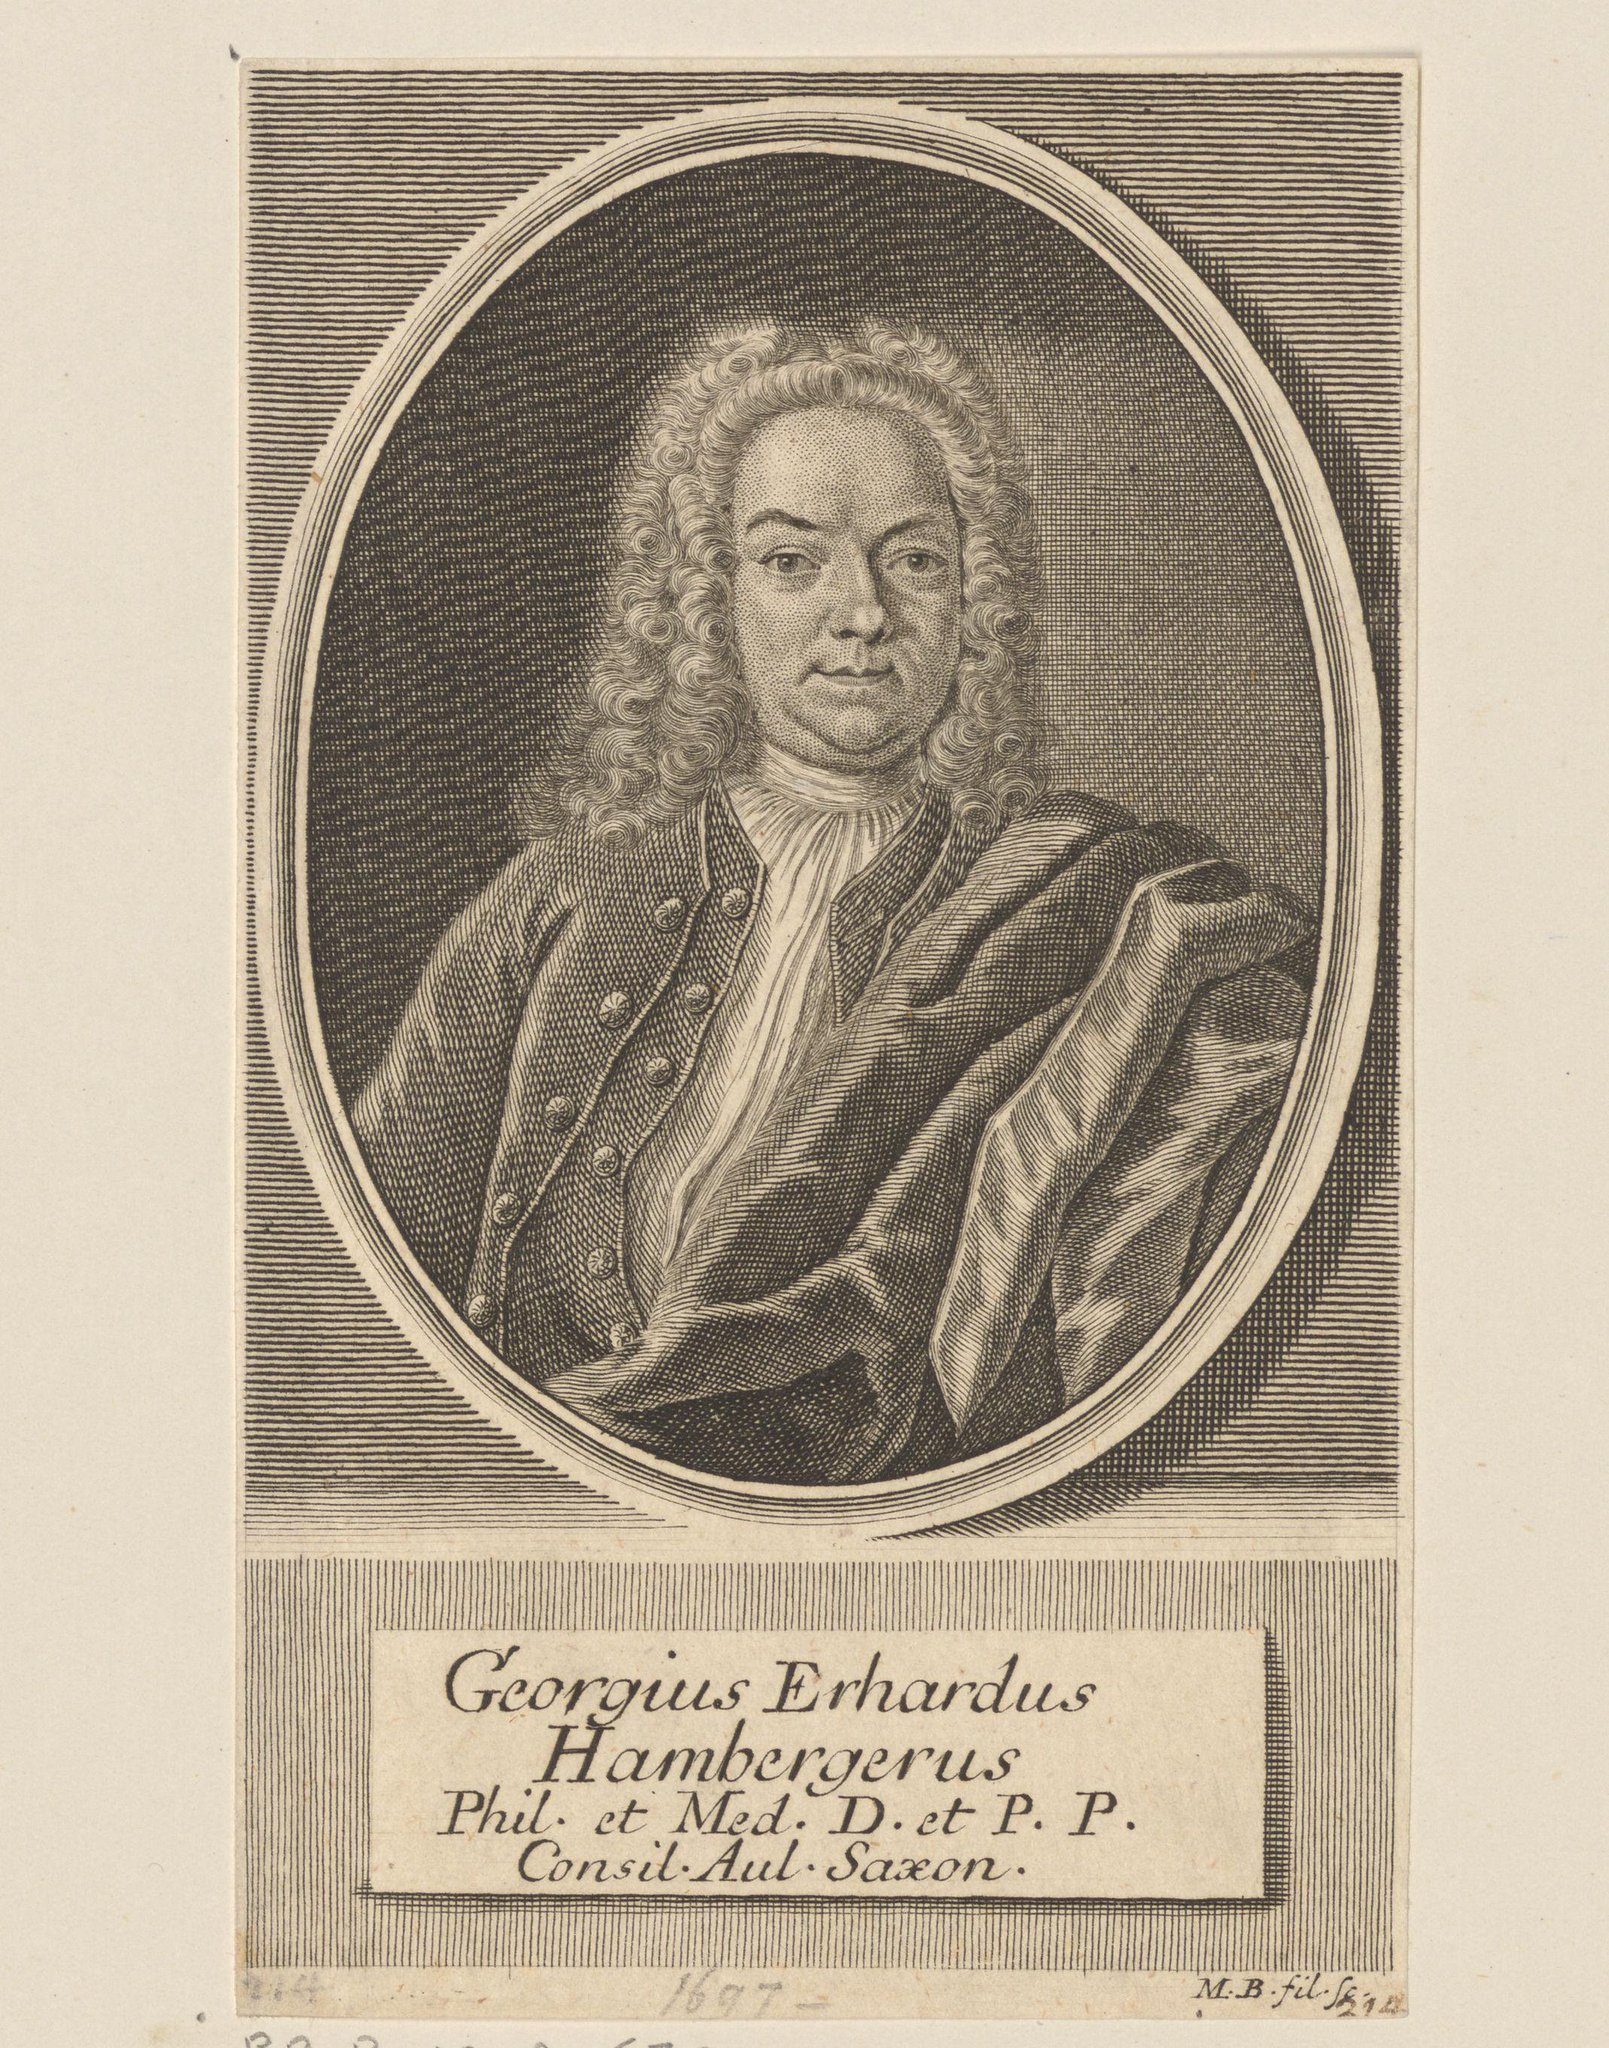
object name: print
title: Portret van Georg Erhard Hamberger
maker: johann martin bernigeroth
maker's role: print maker, publisher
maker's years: 1713-1767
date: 1723-1767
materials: paper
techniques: engraving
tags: physicist, historical persons, physician, doctor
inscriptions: collector's mark: Lugt 2233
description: Prent gebruikt in: Deutsche Acta Eruditorum (...). Leipzig: Johann Gottlieb Gleditsch, 1737, dl. 214.